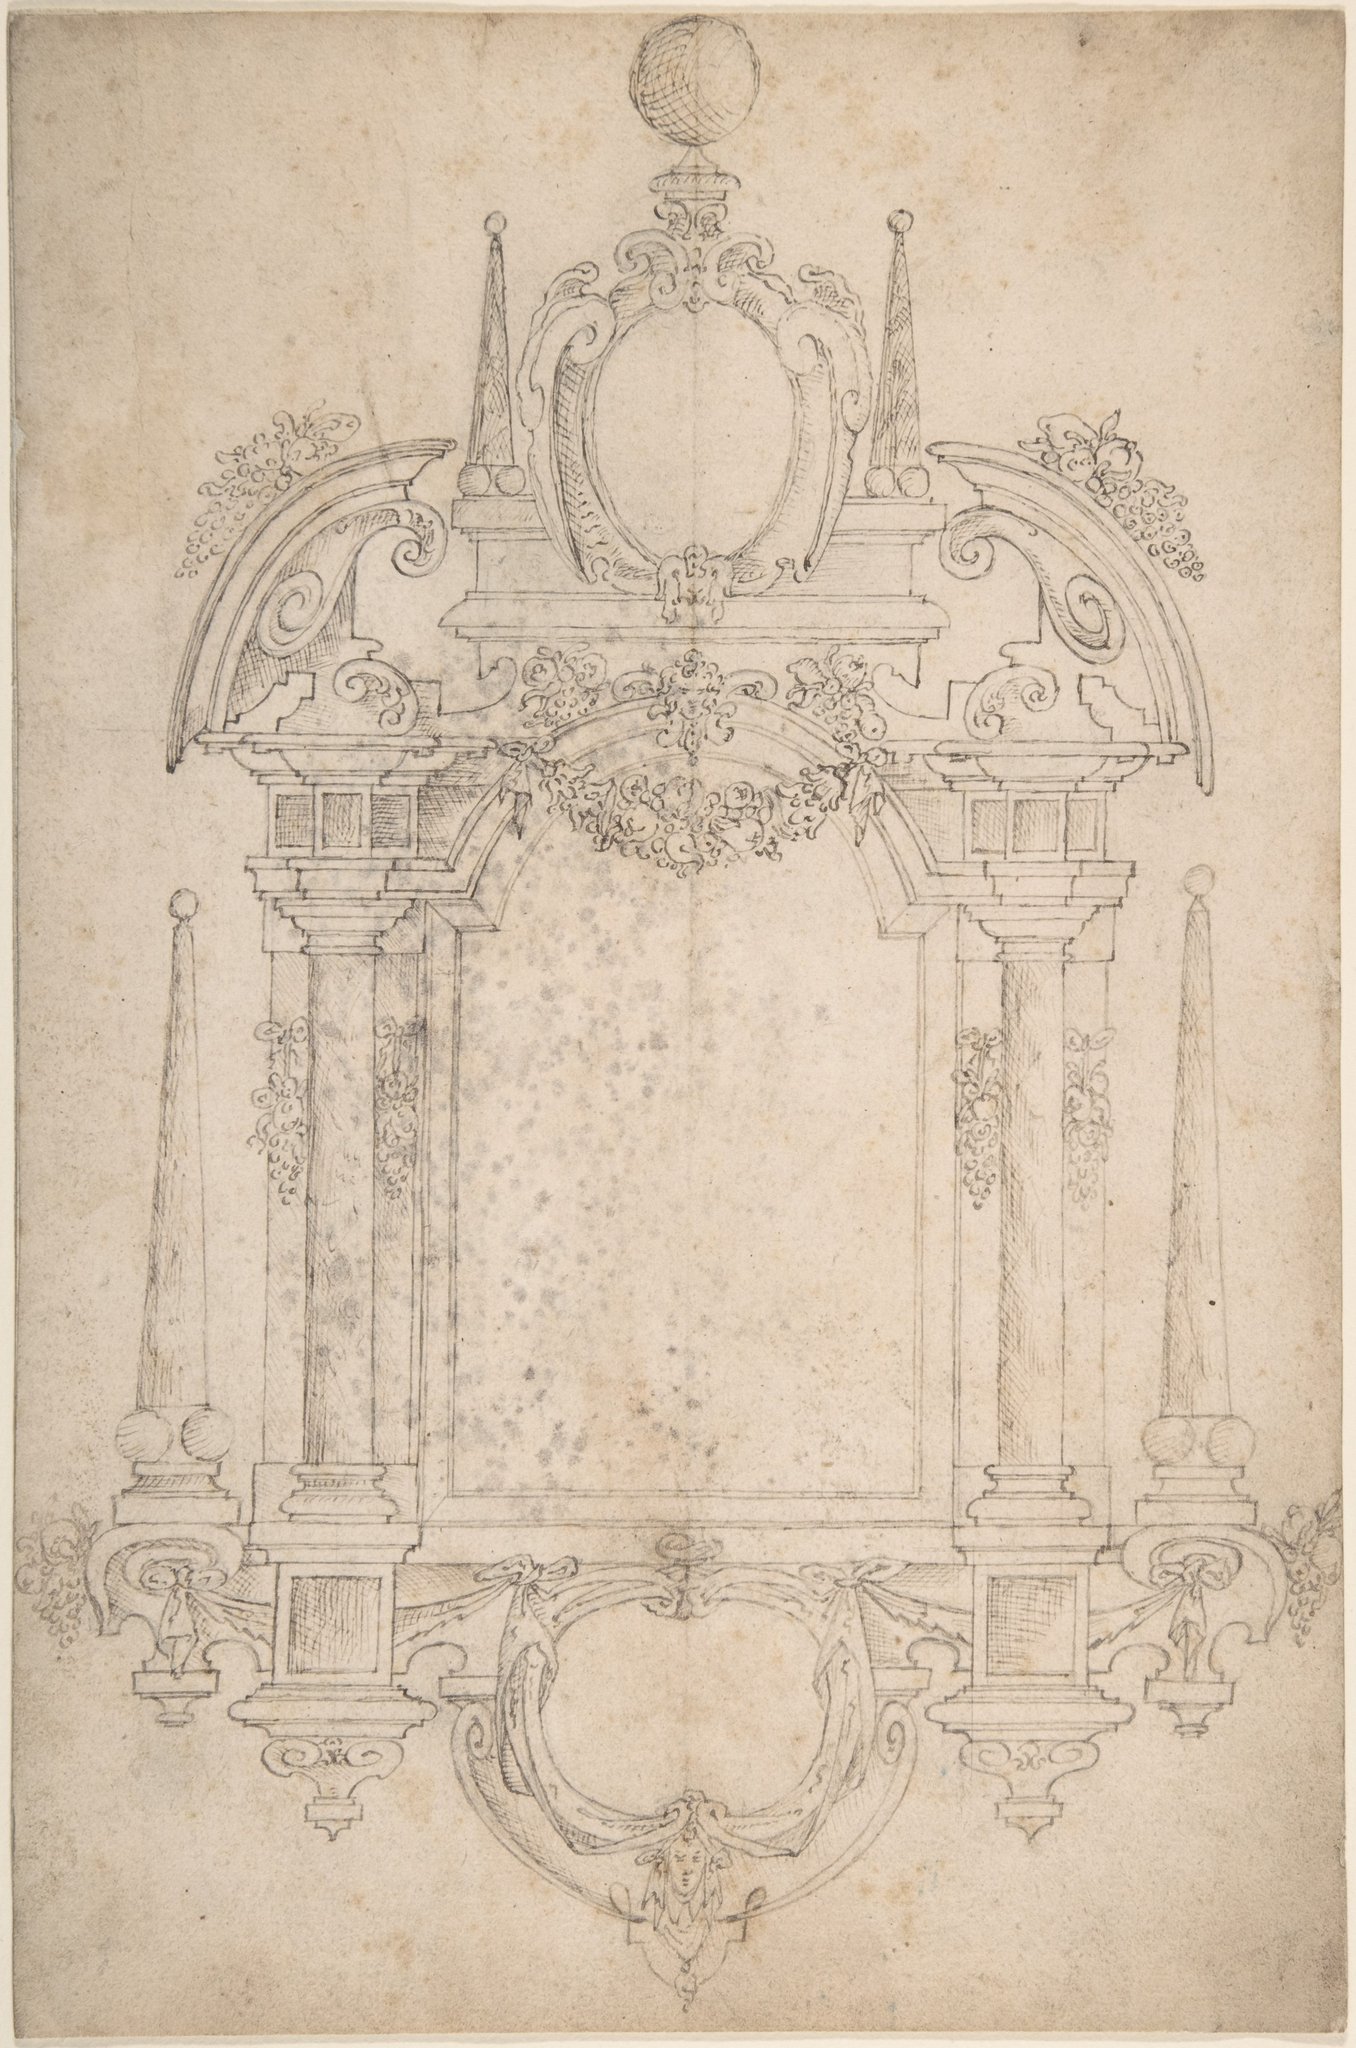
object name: drawing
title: Design for a Tomb or Wall Monument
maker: anonymous, italian, 17th century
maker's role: artist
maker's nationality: italian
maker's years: 1600-1700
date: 1601-1700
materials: graphite, ink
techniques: pen, drawing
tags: monuments